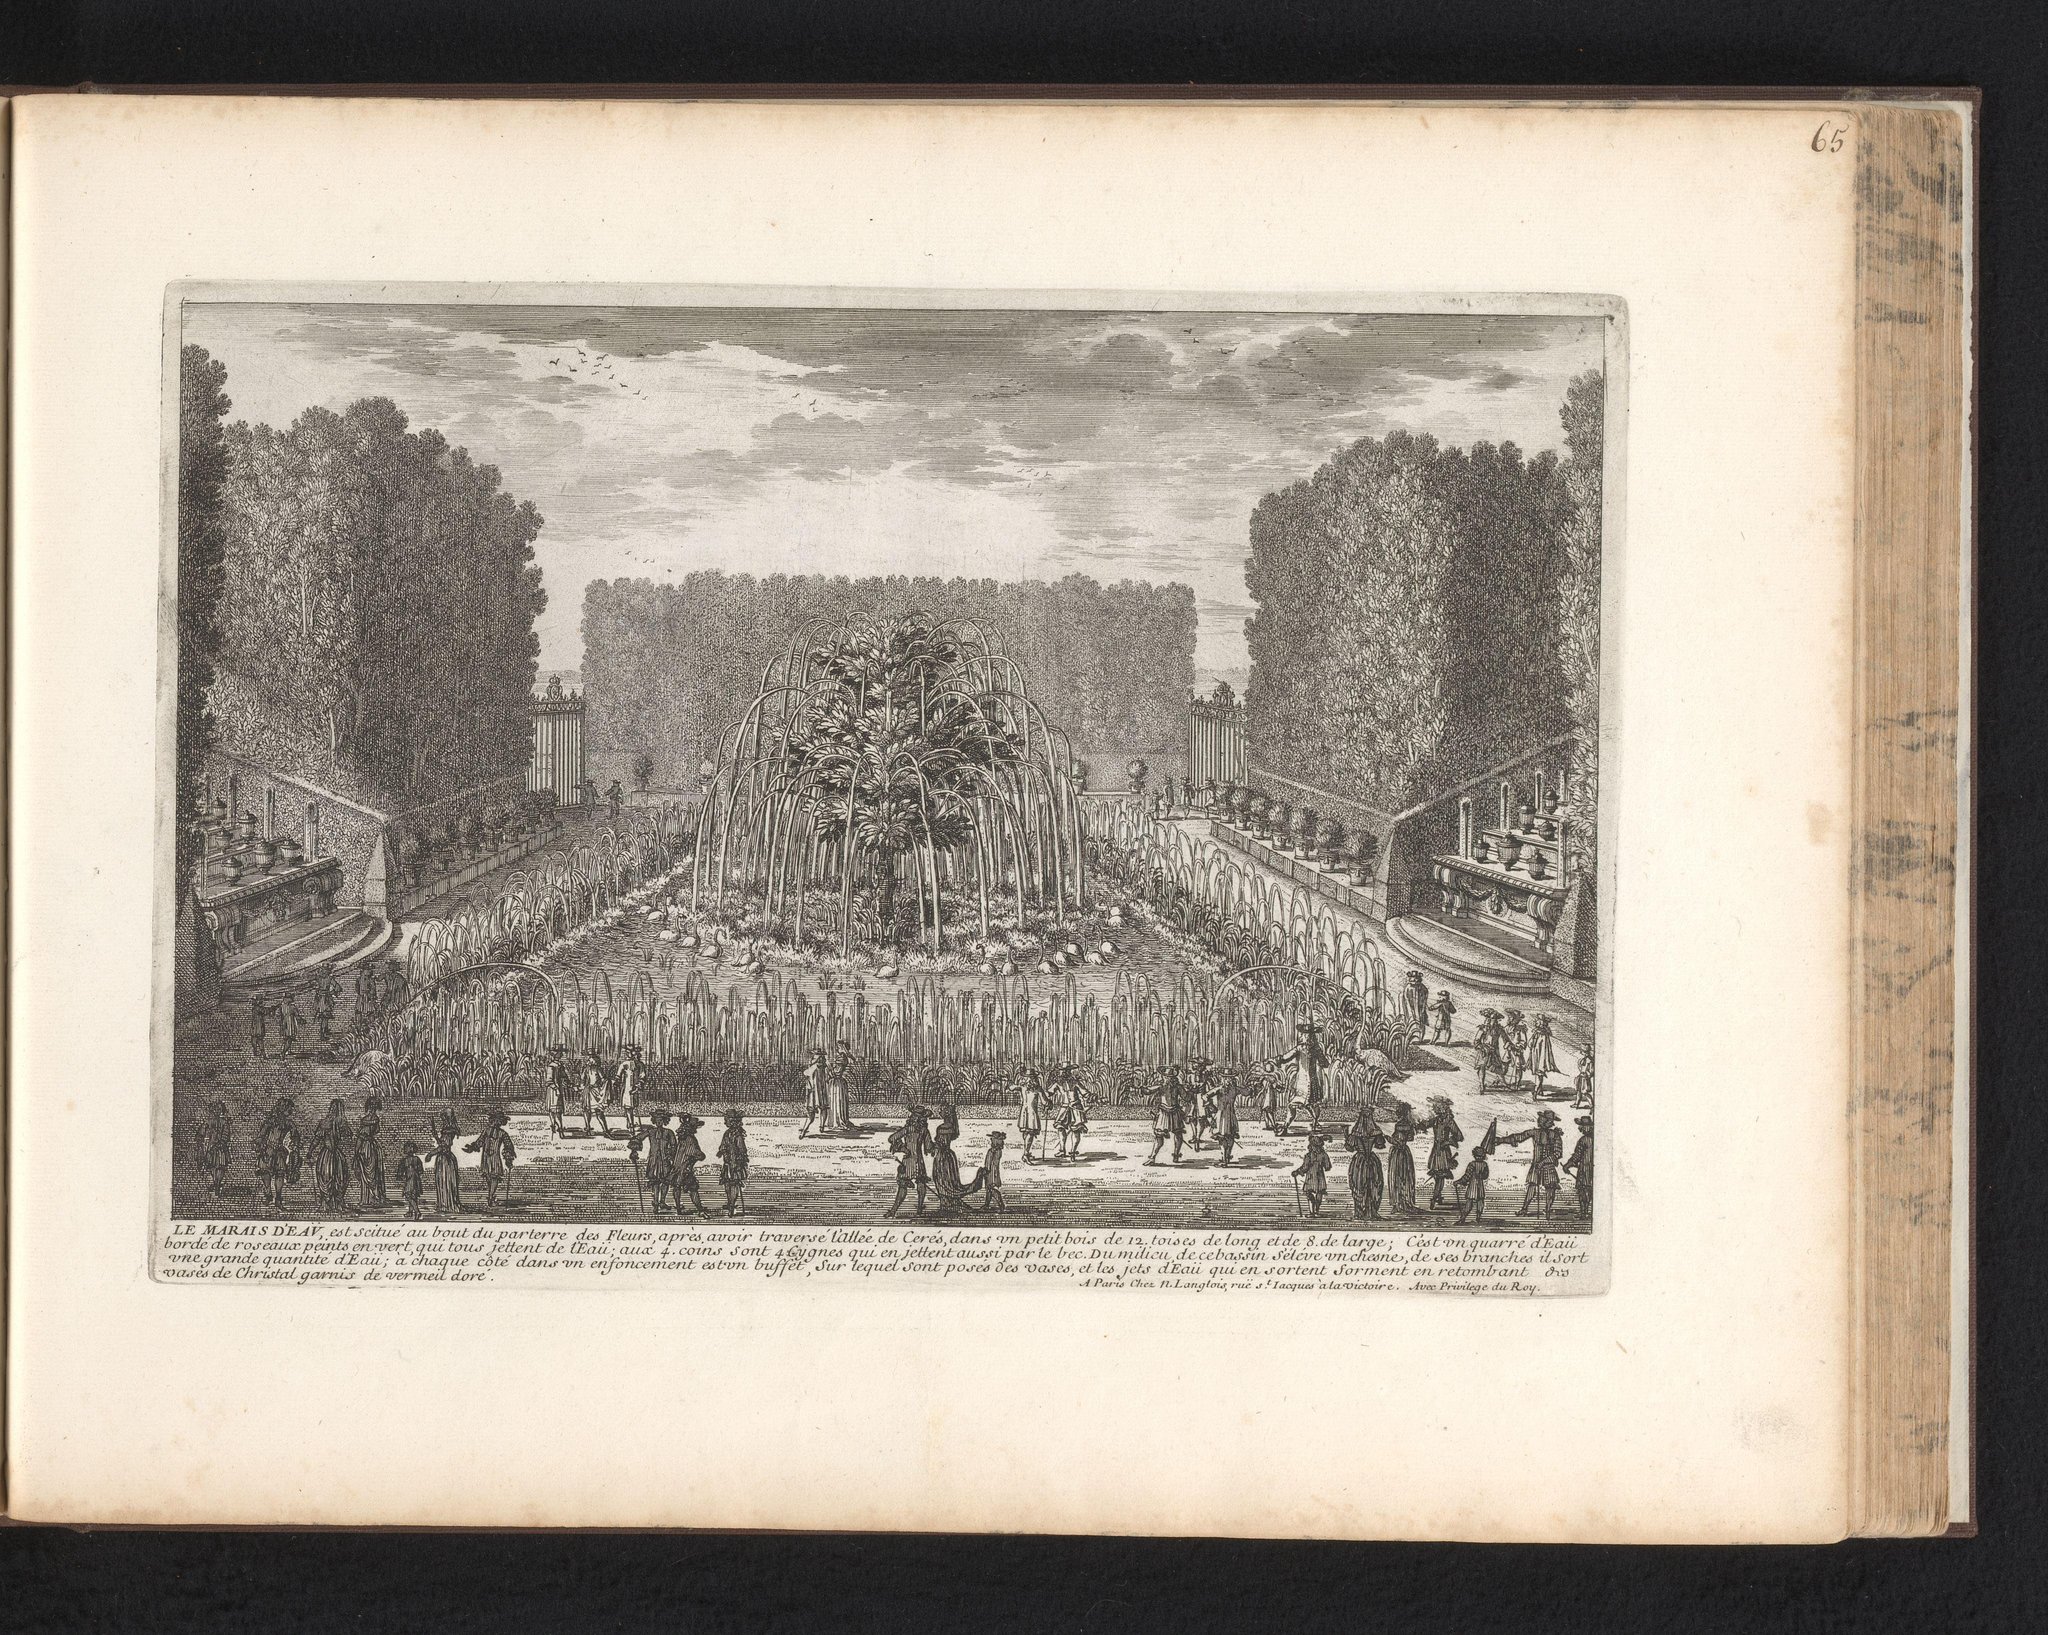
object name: album leaf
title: Le Marais d'Eau (...)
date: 1670-1703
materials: paper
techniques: etching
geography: paris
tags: plants; vegetation, garden fountain, french or architectonic garden; formal garden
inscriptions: collector's mark: Lugt 2228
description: Prenten met het signatuur 'Perelle' kunnen zowel door vader Gabriel als door zonen Nicolas en Adam gemaakt zijn. De uitgevers vader en zoon Nicolas Langlois worden allebei vermeld als N. Langlois op hetzelfde adres.